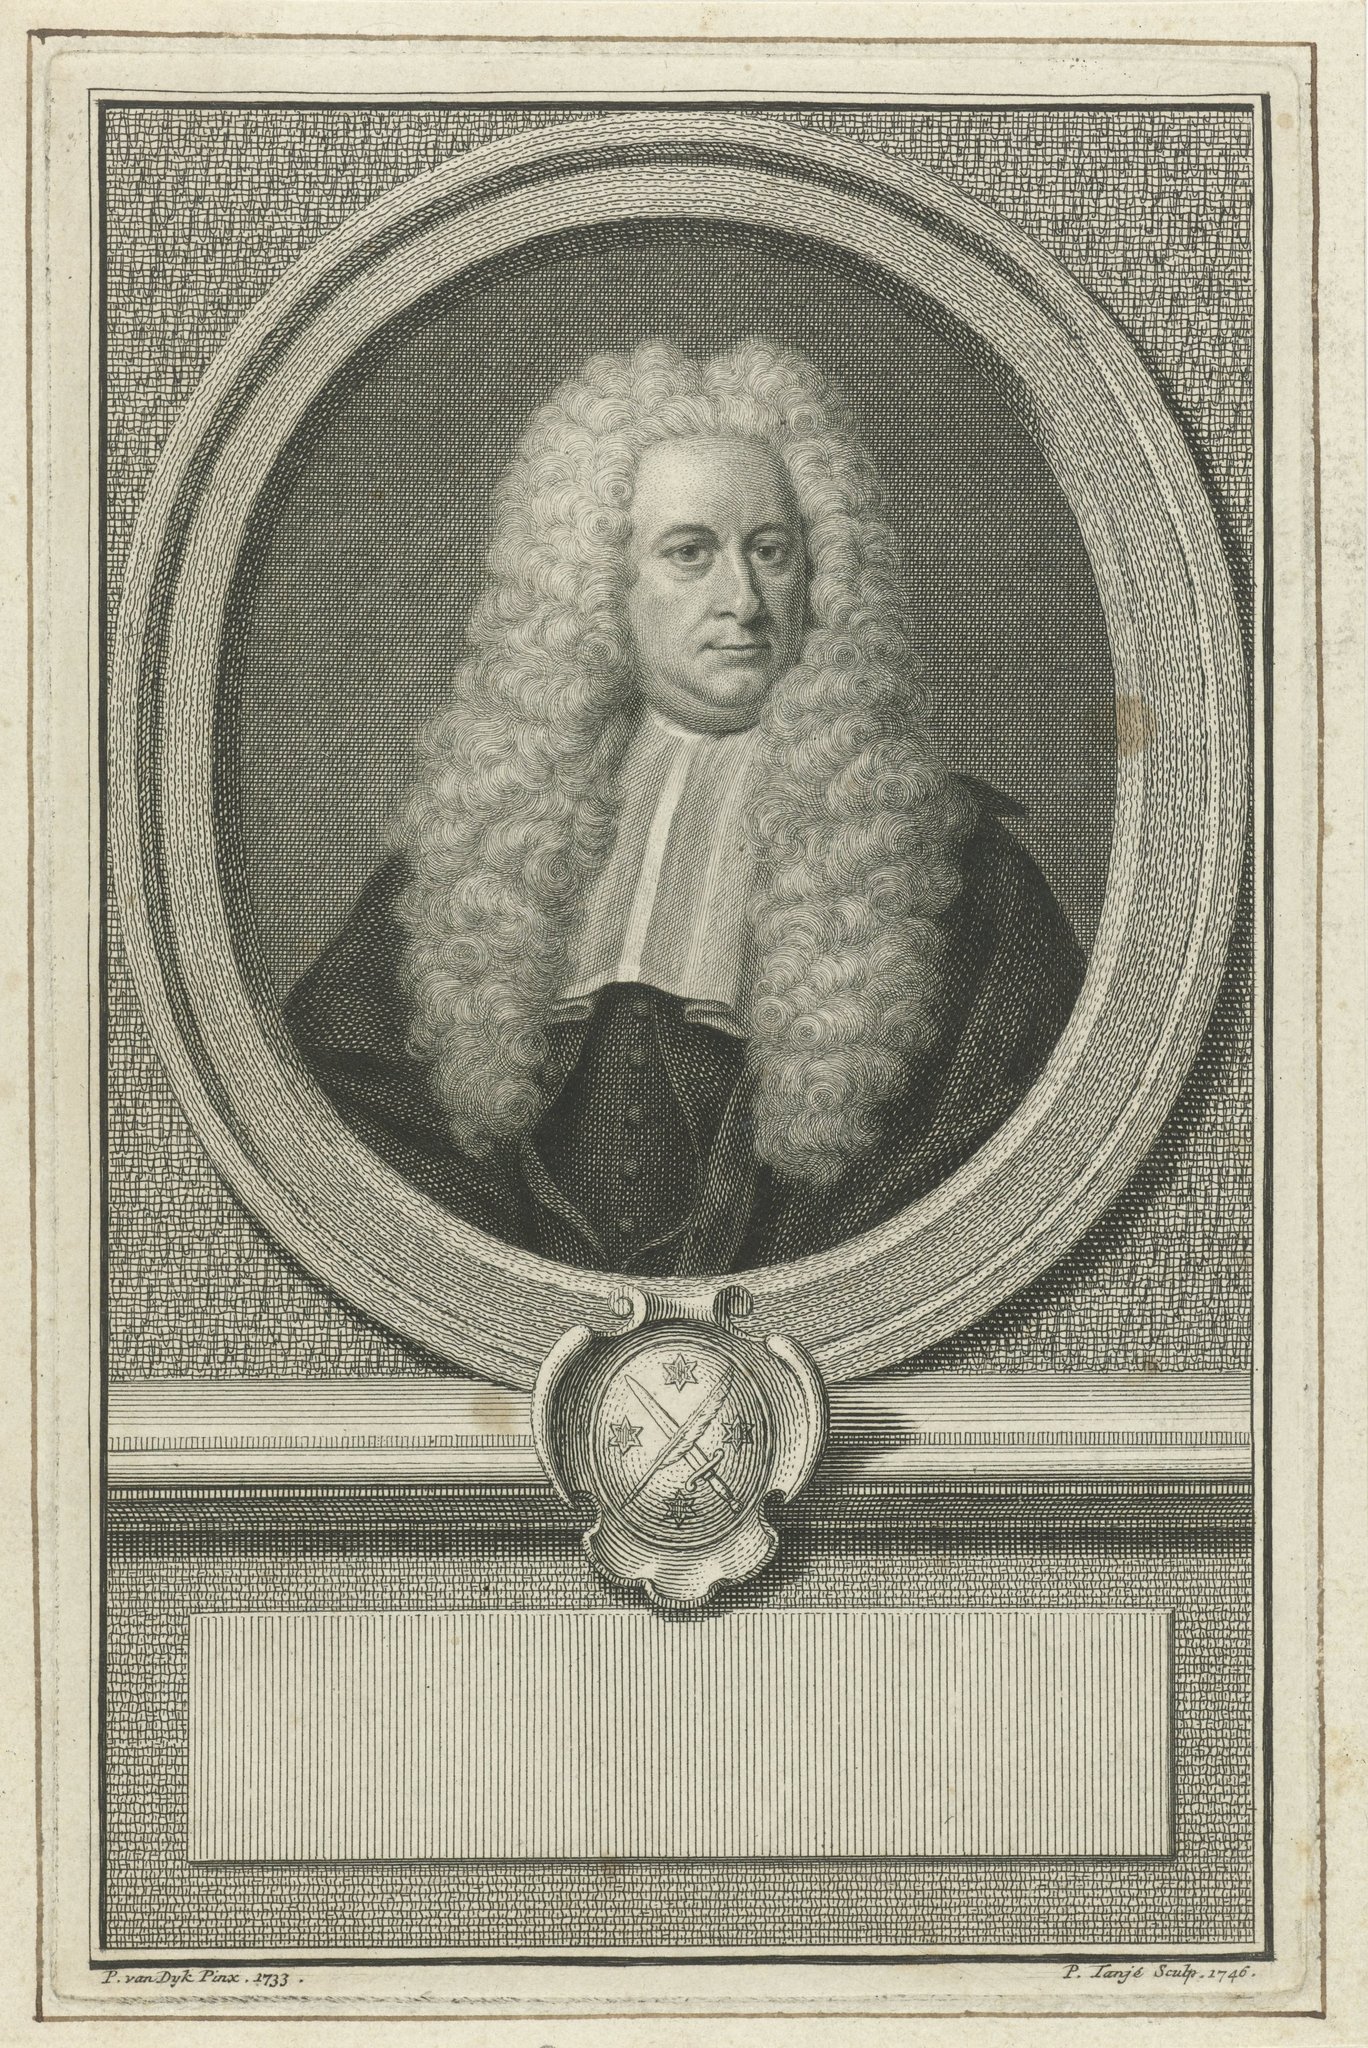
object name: print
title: Portret van Cornelis van Bynkershoek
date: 1746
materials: paper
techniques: engraving, etching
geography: amsterdam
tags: cornelis van bynkershoek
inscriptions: collector's mark: Lugt 2228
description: Portret van Cornelis van Bynkershoek, president van de Hoge Raad van Holland, Zeeland en Friesland. Middenonder zijn wapenschild.